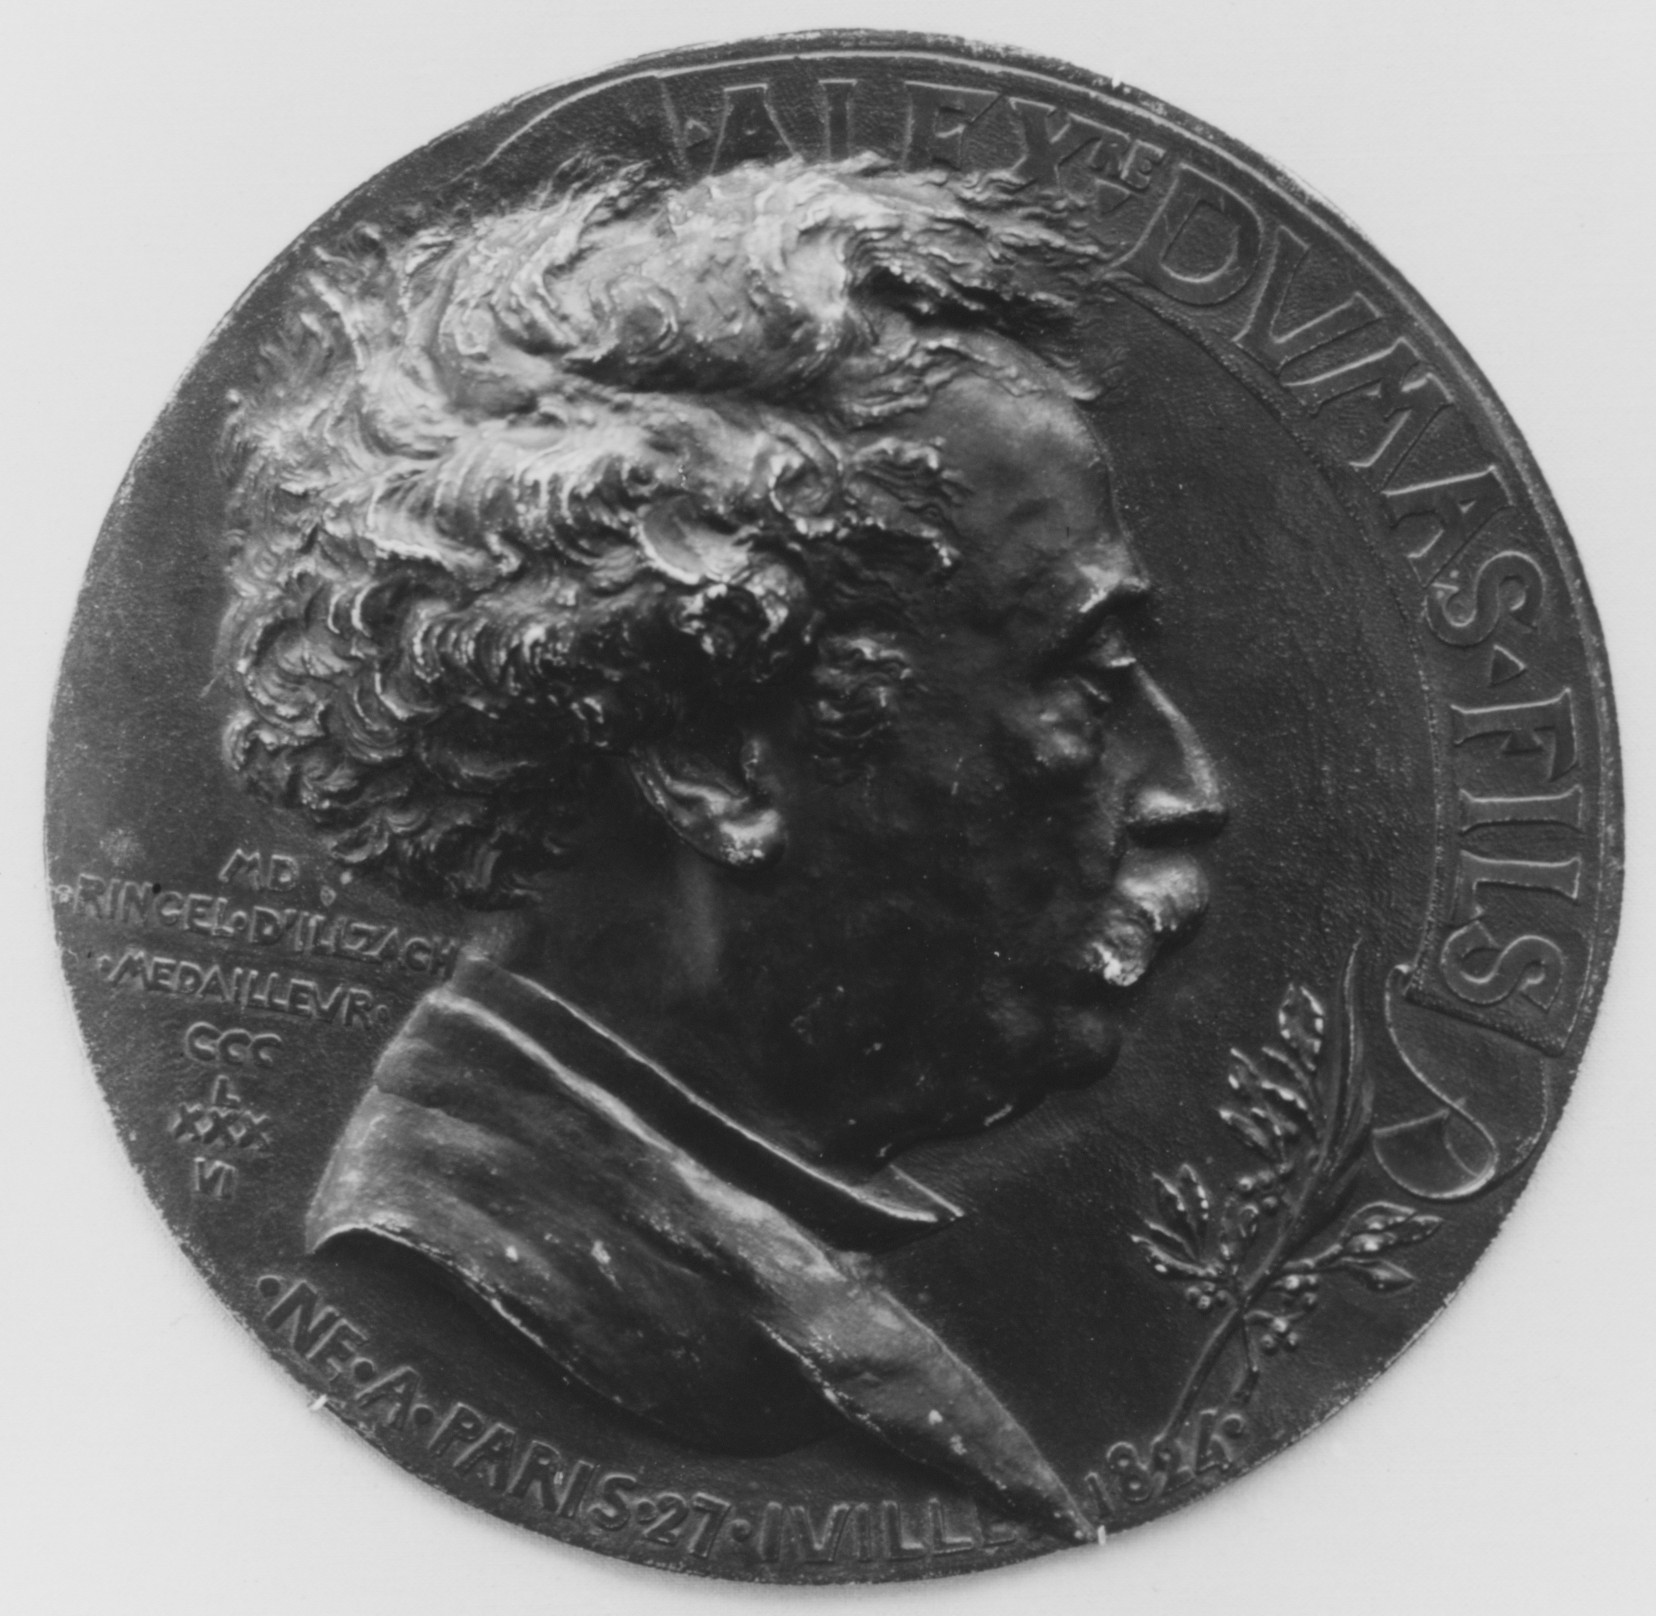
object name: medallion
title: Alexandre Dumas the Younger (1824-1895)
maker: jean-désiré ringel d'illzach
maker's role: artist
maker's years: 1847-1916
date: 1886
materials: bronze, patina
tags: men,profiles